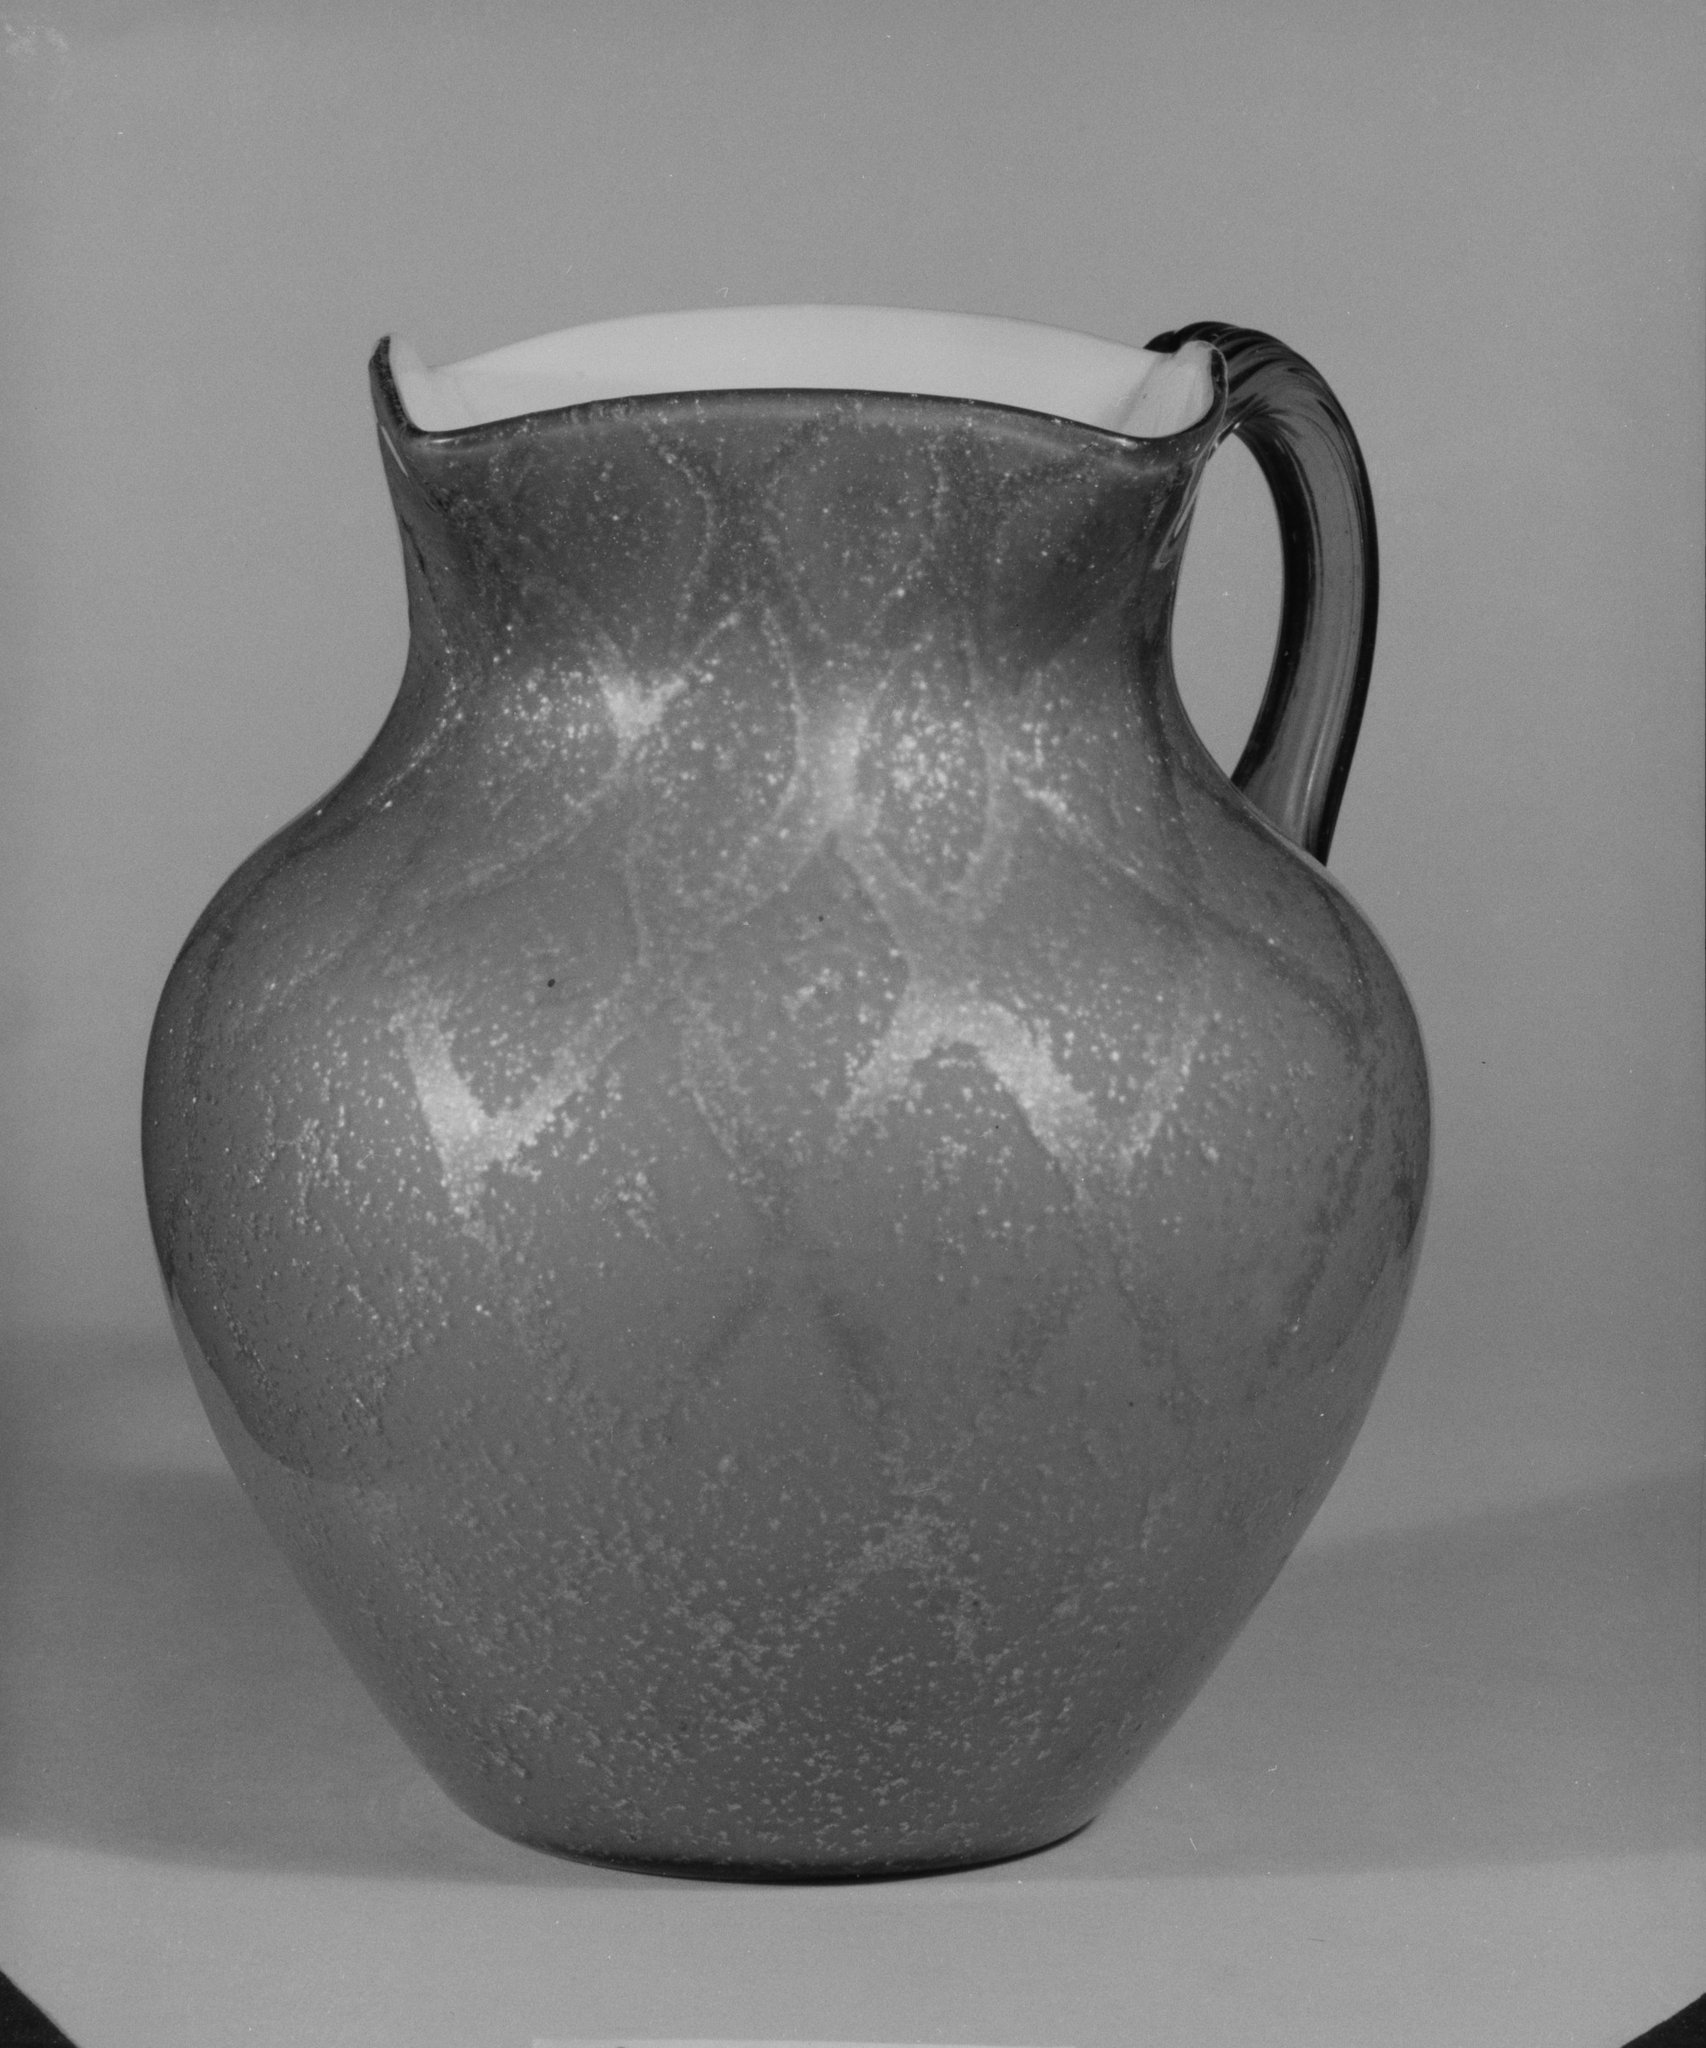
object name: pitcher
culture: american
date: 1870-1890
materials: amber, glass, mica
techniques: glassblowing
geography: united states